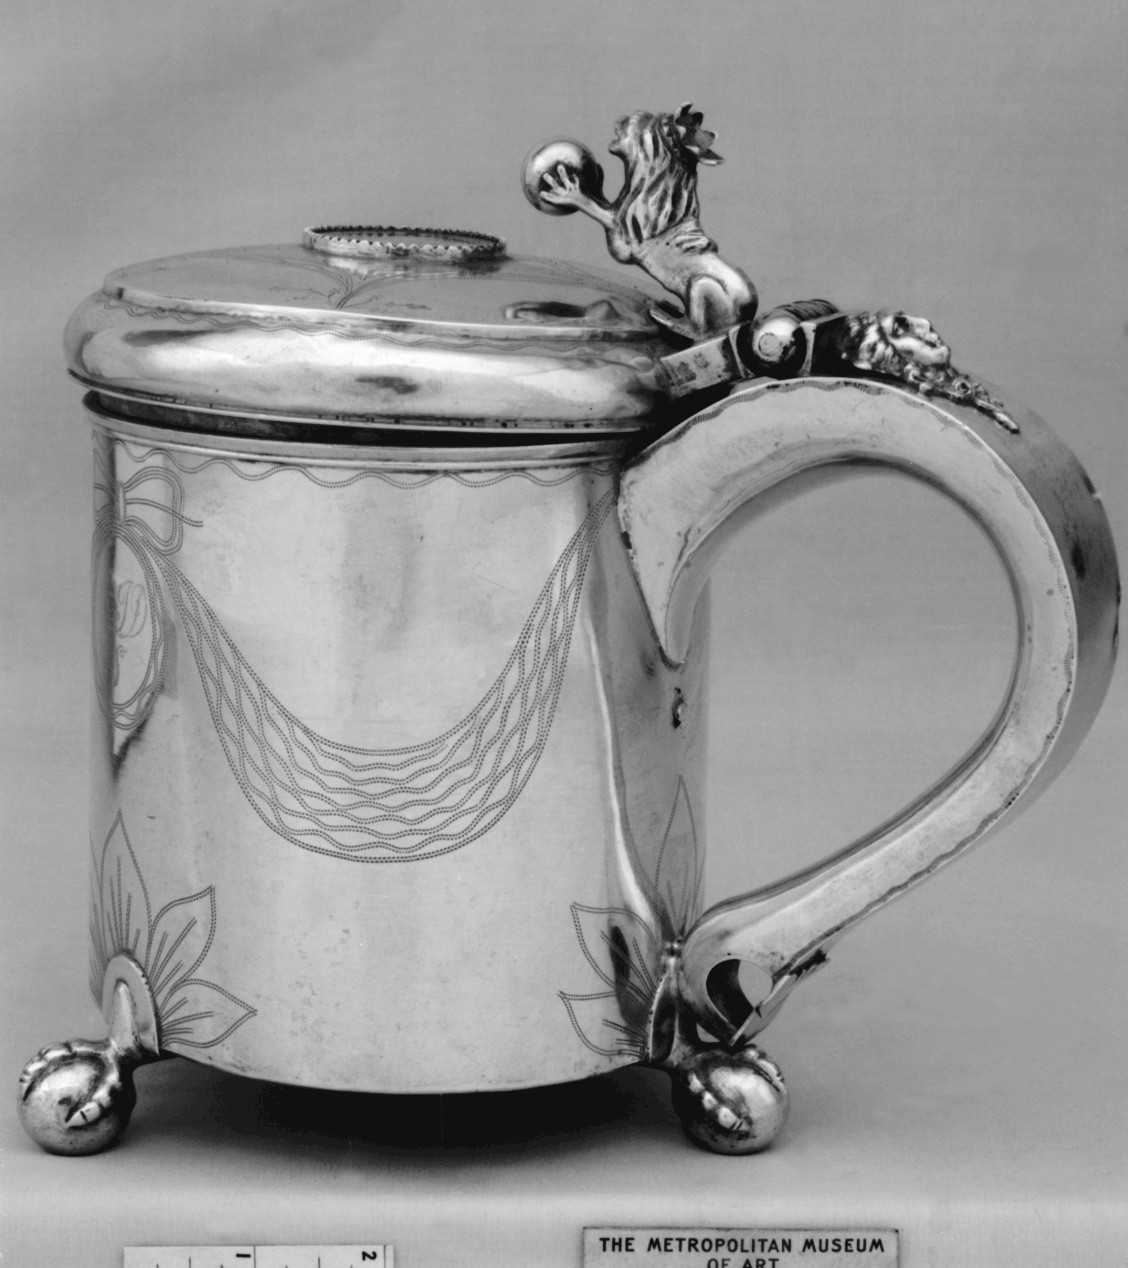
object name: peg tankard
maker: isack andersen feldthus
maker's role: maker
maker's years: 1811-1860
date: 1812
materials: silver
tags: animals